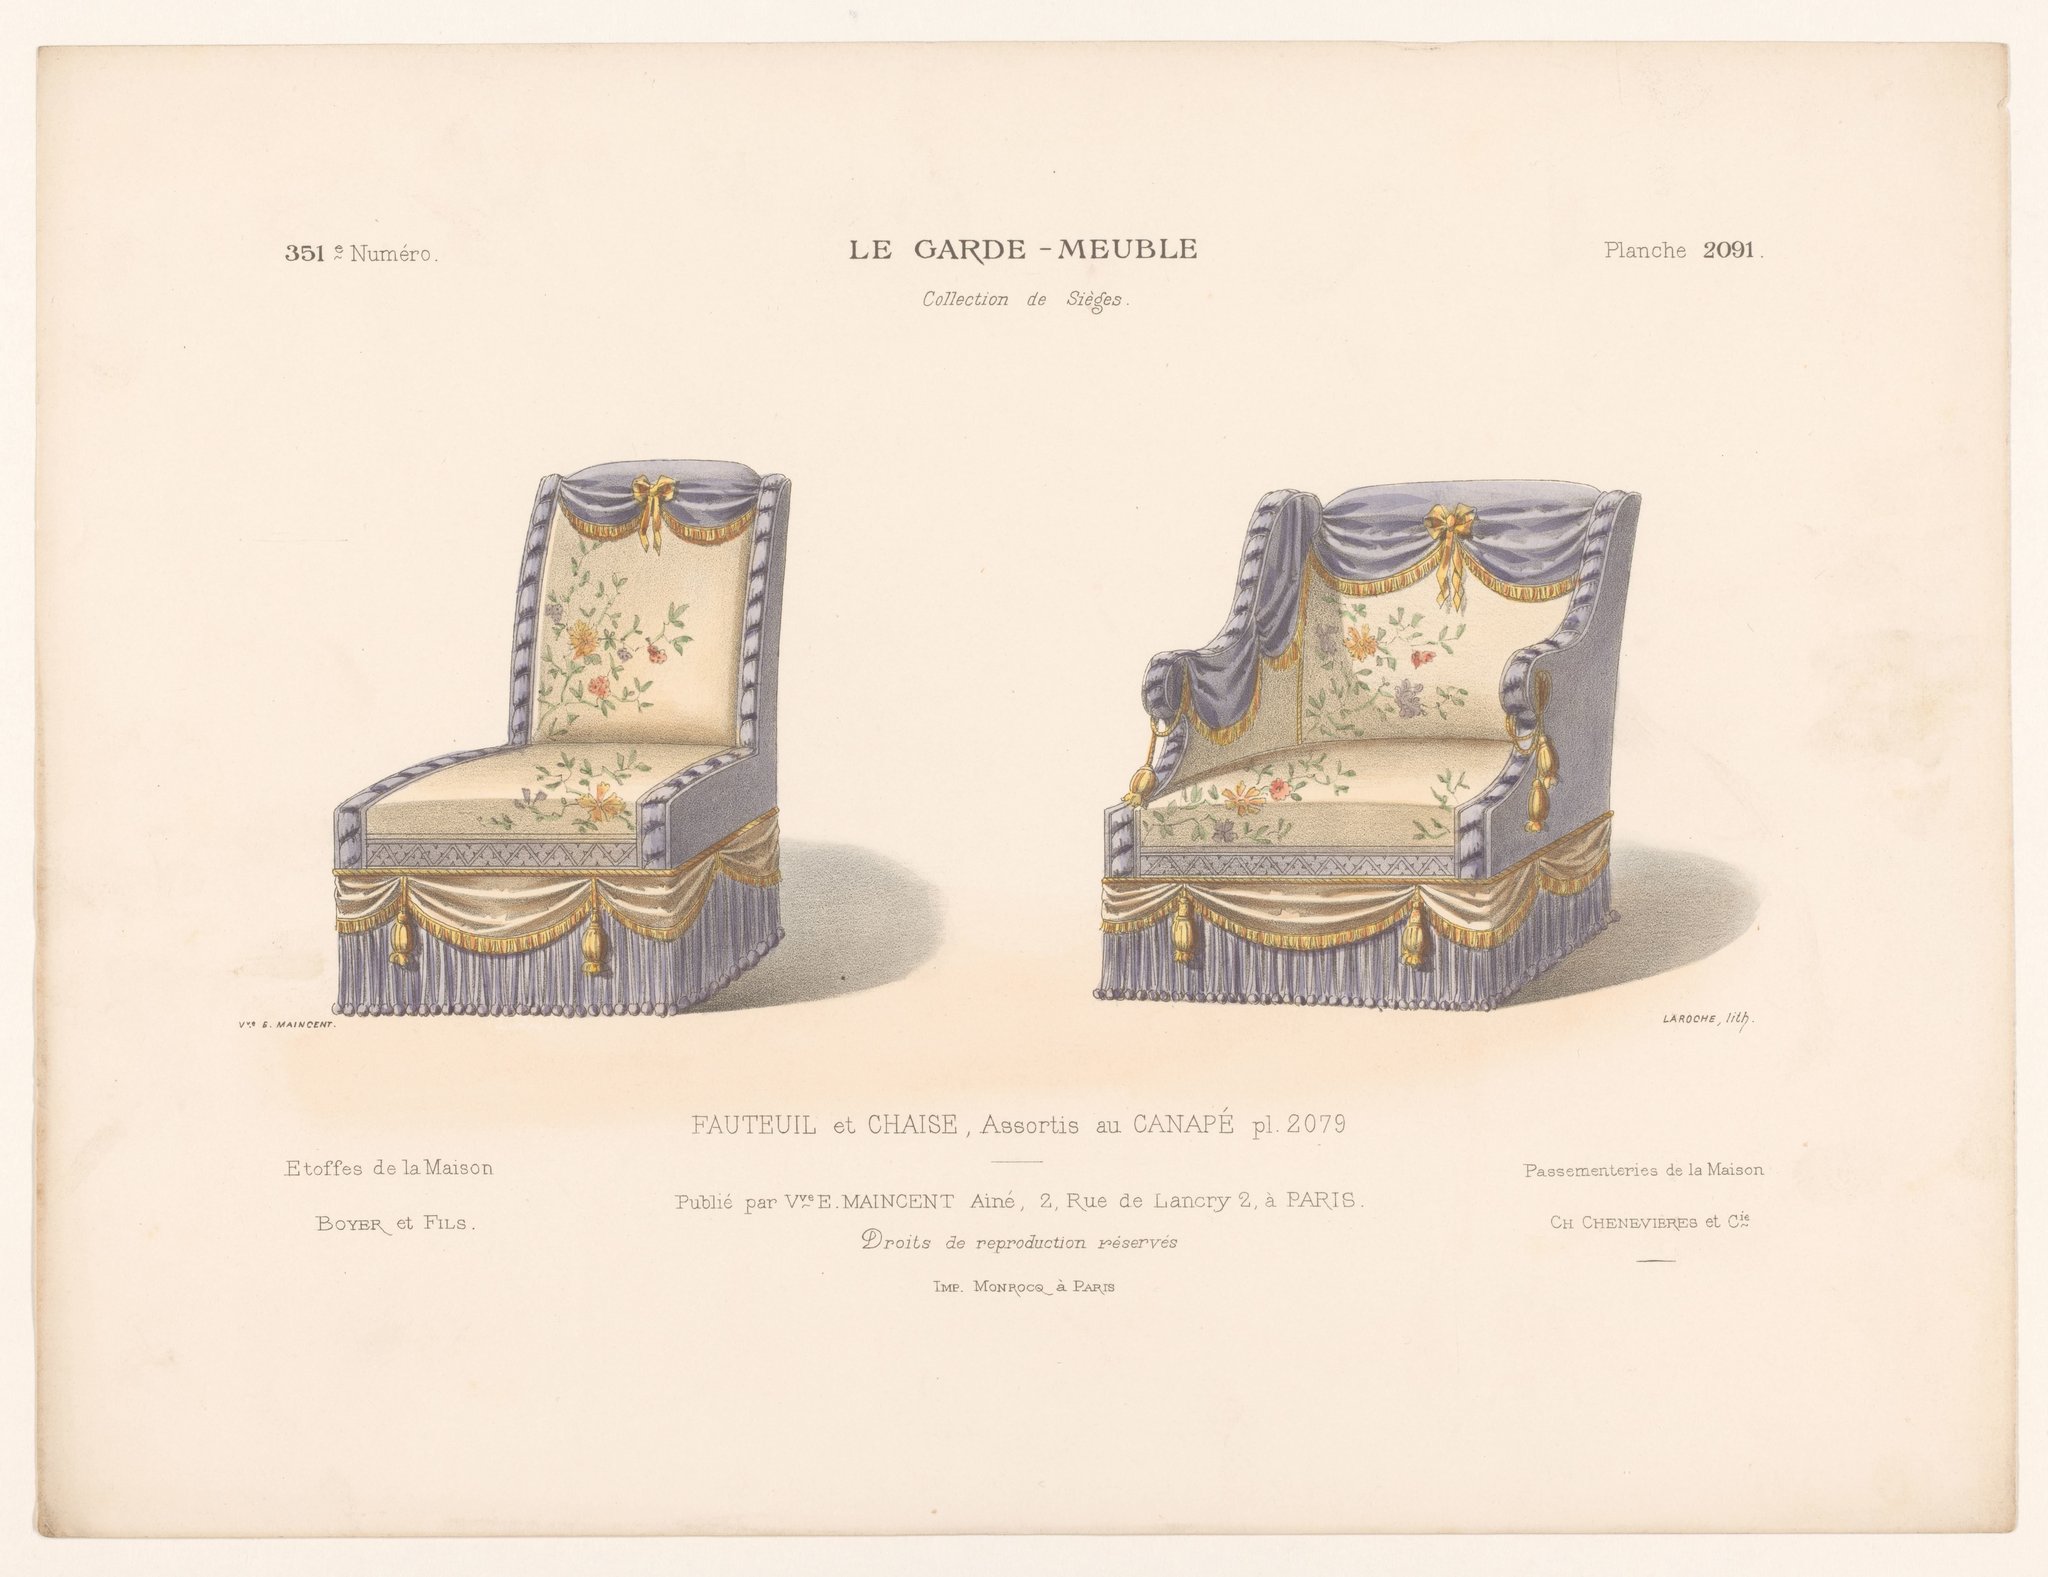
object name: print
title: Le garde-meuble / Collection de Sièges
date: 1895-1935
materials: paper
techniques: hand coloring, lithograph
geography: paris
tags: seating furniture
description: Ieder Livraison in de serie Le Garde-Meuble bevat negen platen: drie 'sièges' (zitmeubels), drie 'meubles' (diverse meubels zoals tafels en kasten) en drie 'tentures' (gordijnen en draperieën).